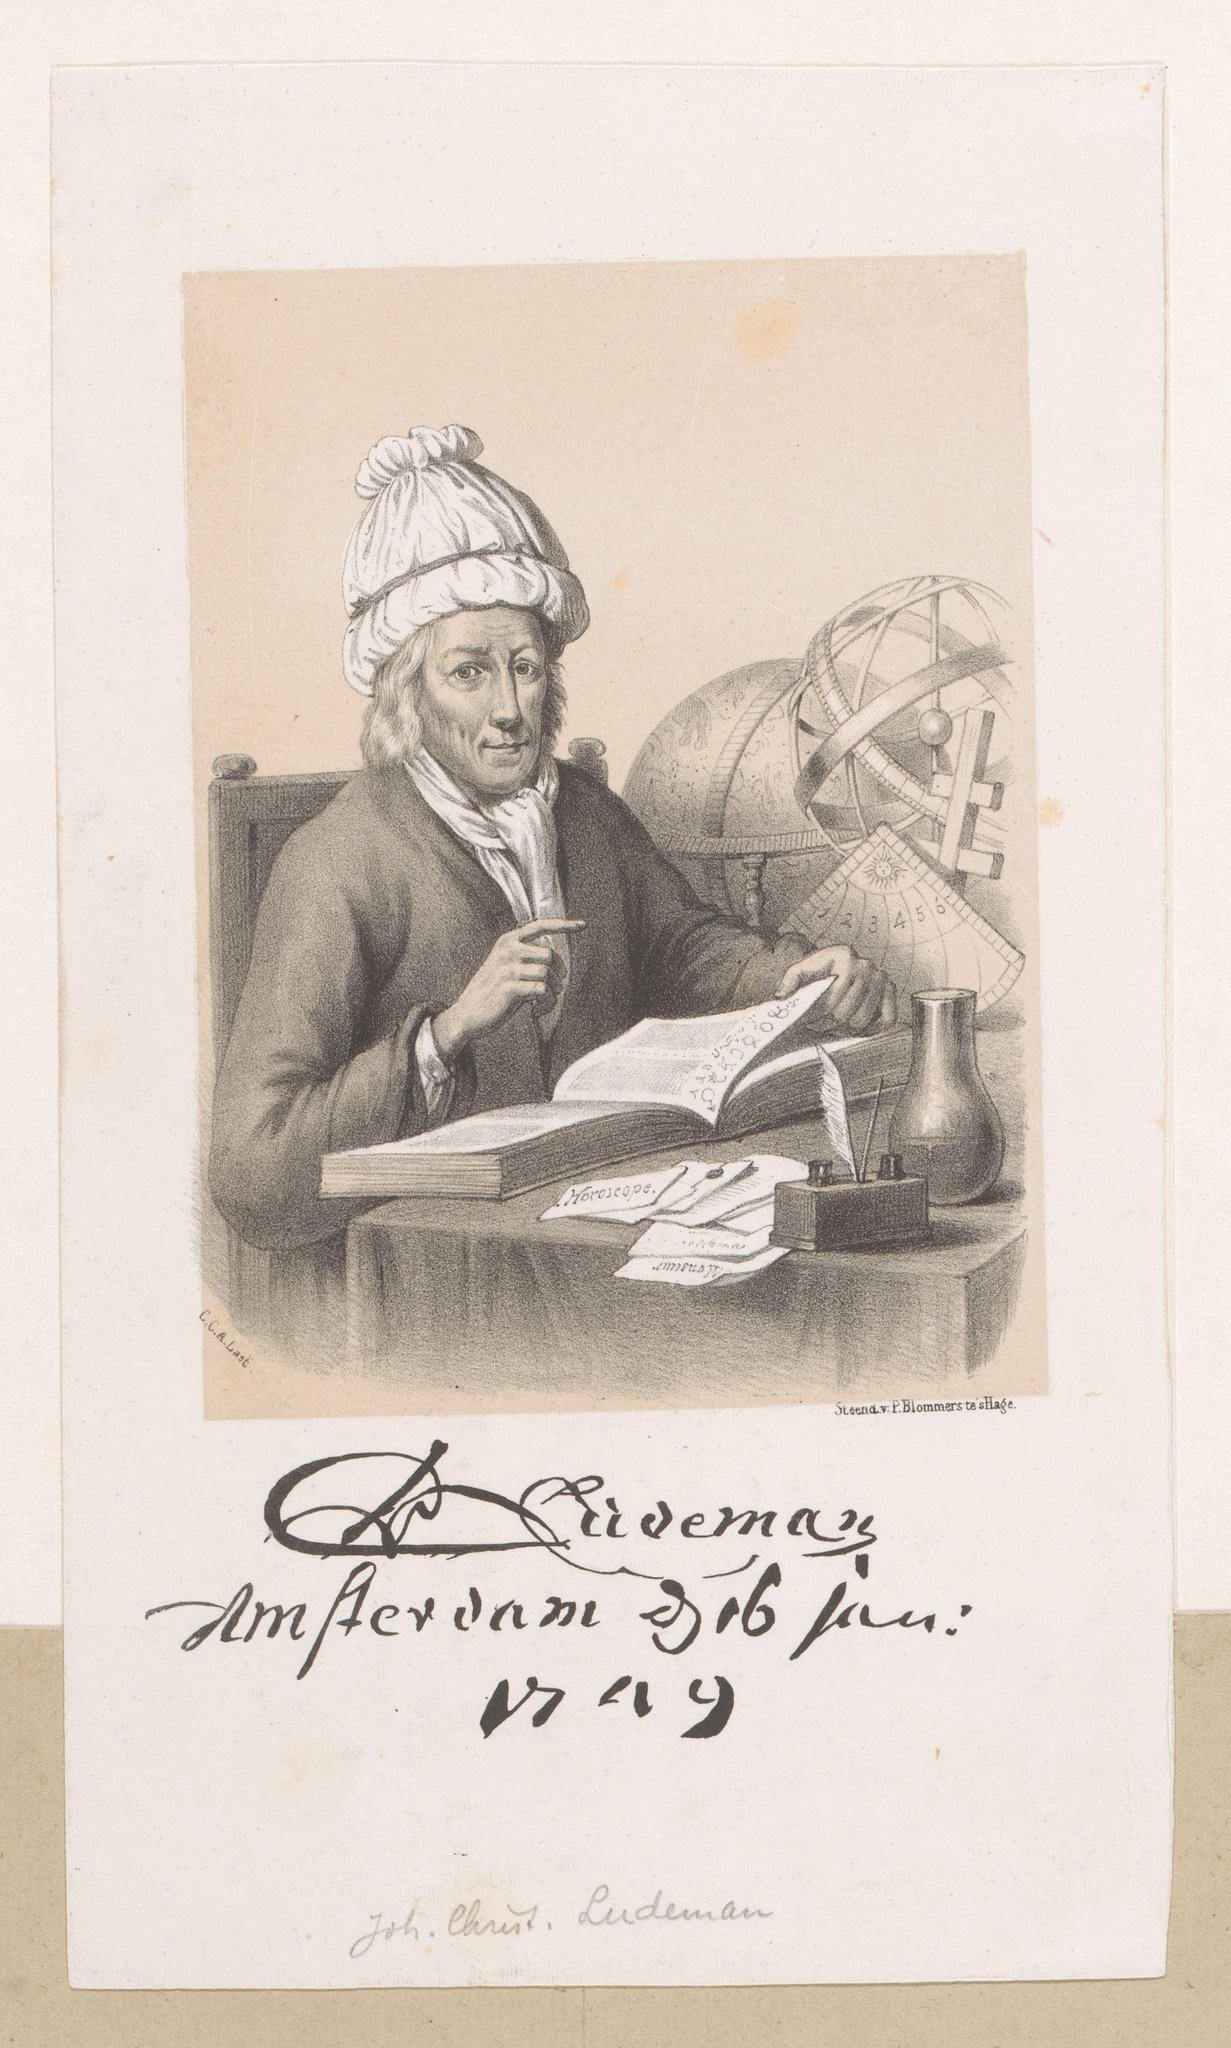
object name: print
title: Portret van Johan Christophorus Ludeman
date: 1818-1876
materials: paper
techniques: tone lithography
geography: the hague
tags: amsterdam, horoscope, astronomical instruments, globe, historical persons (+ (full) bust portrait)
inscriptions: collector's mark: Lugt 2228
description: Ludeman was een alternatieve geneesheer en waarzegger. Hij is afgebeeld te midden van papieren met horoscopen, schrijfgerei, een globe en meetinstrumenten. Onder het portret zijn signatuur uit 1749.